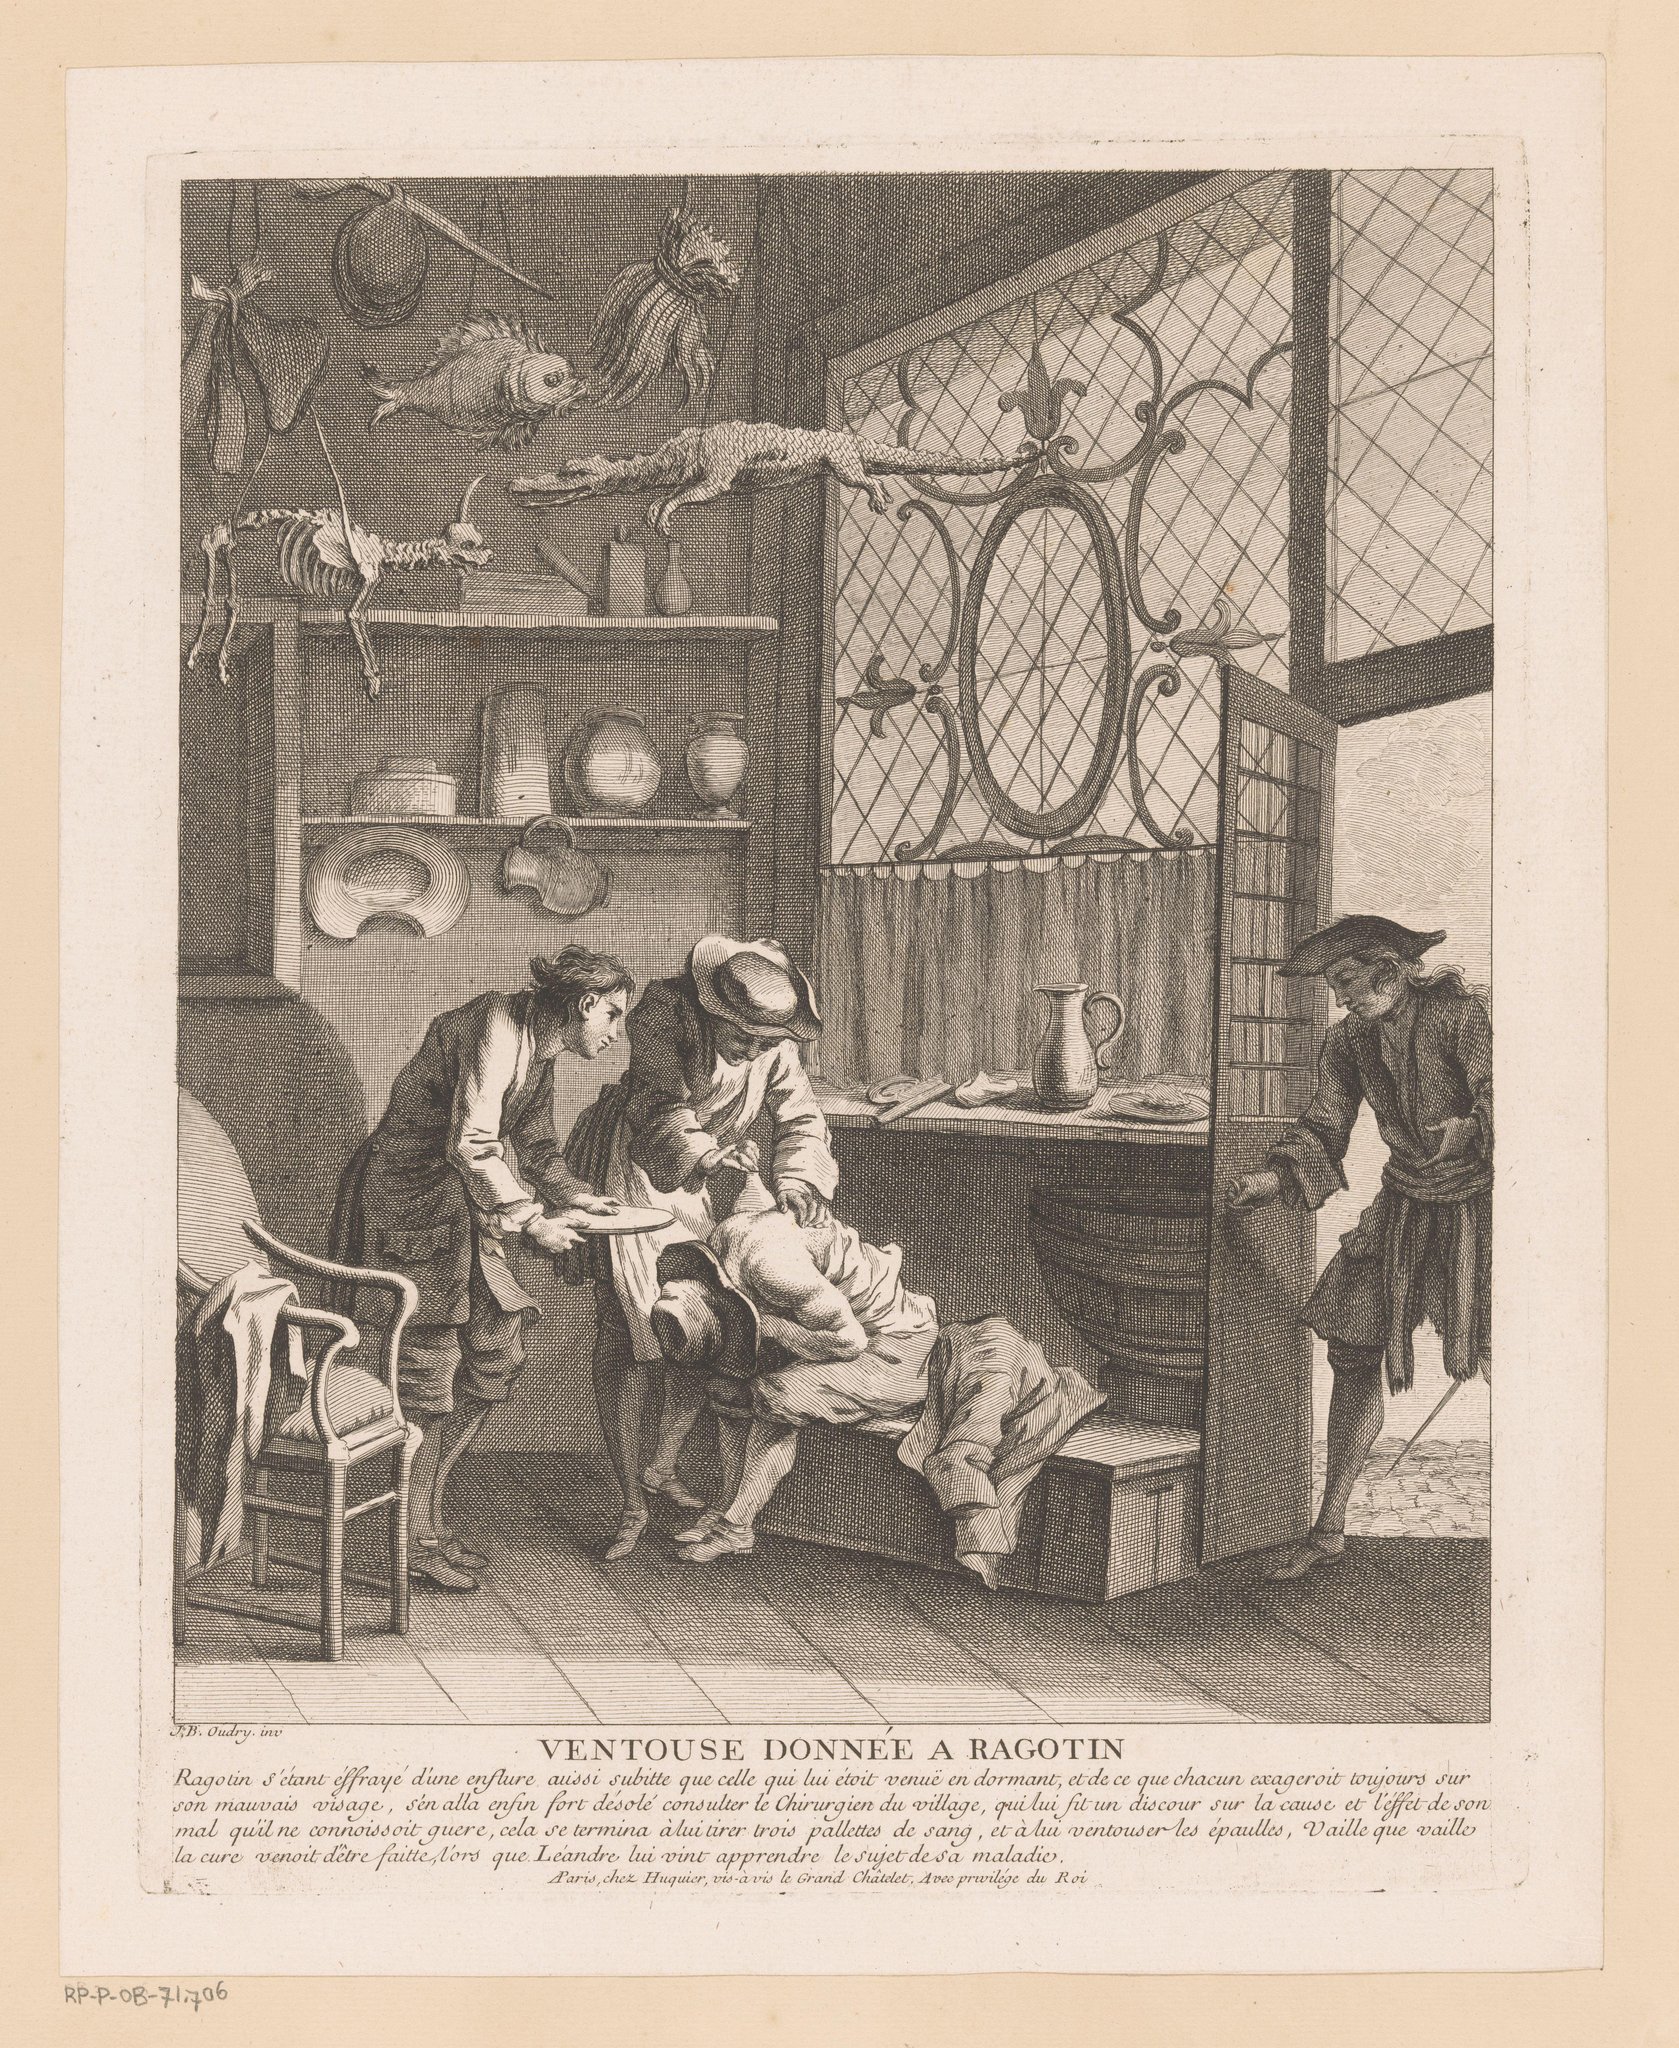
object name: print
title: Ventouse donnée à Ragotin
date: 1705-1772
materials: paper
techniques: engraving, etching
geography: paris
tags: (scarron, roman comique) specific works of literature (with author, title), barber; surgeon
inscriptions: collector's mark: Lugt 240